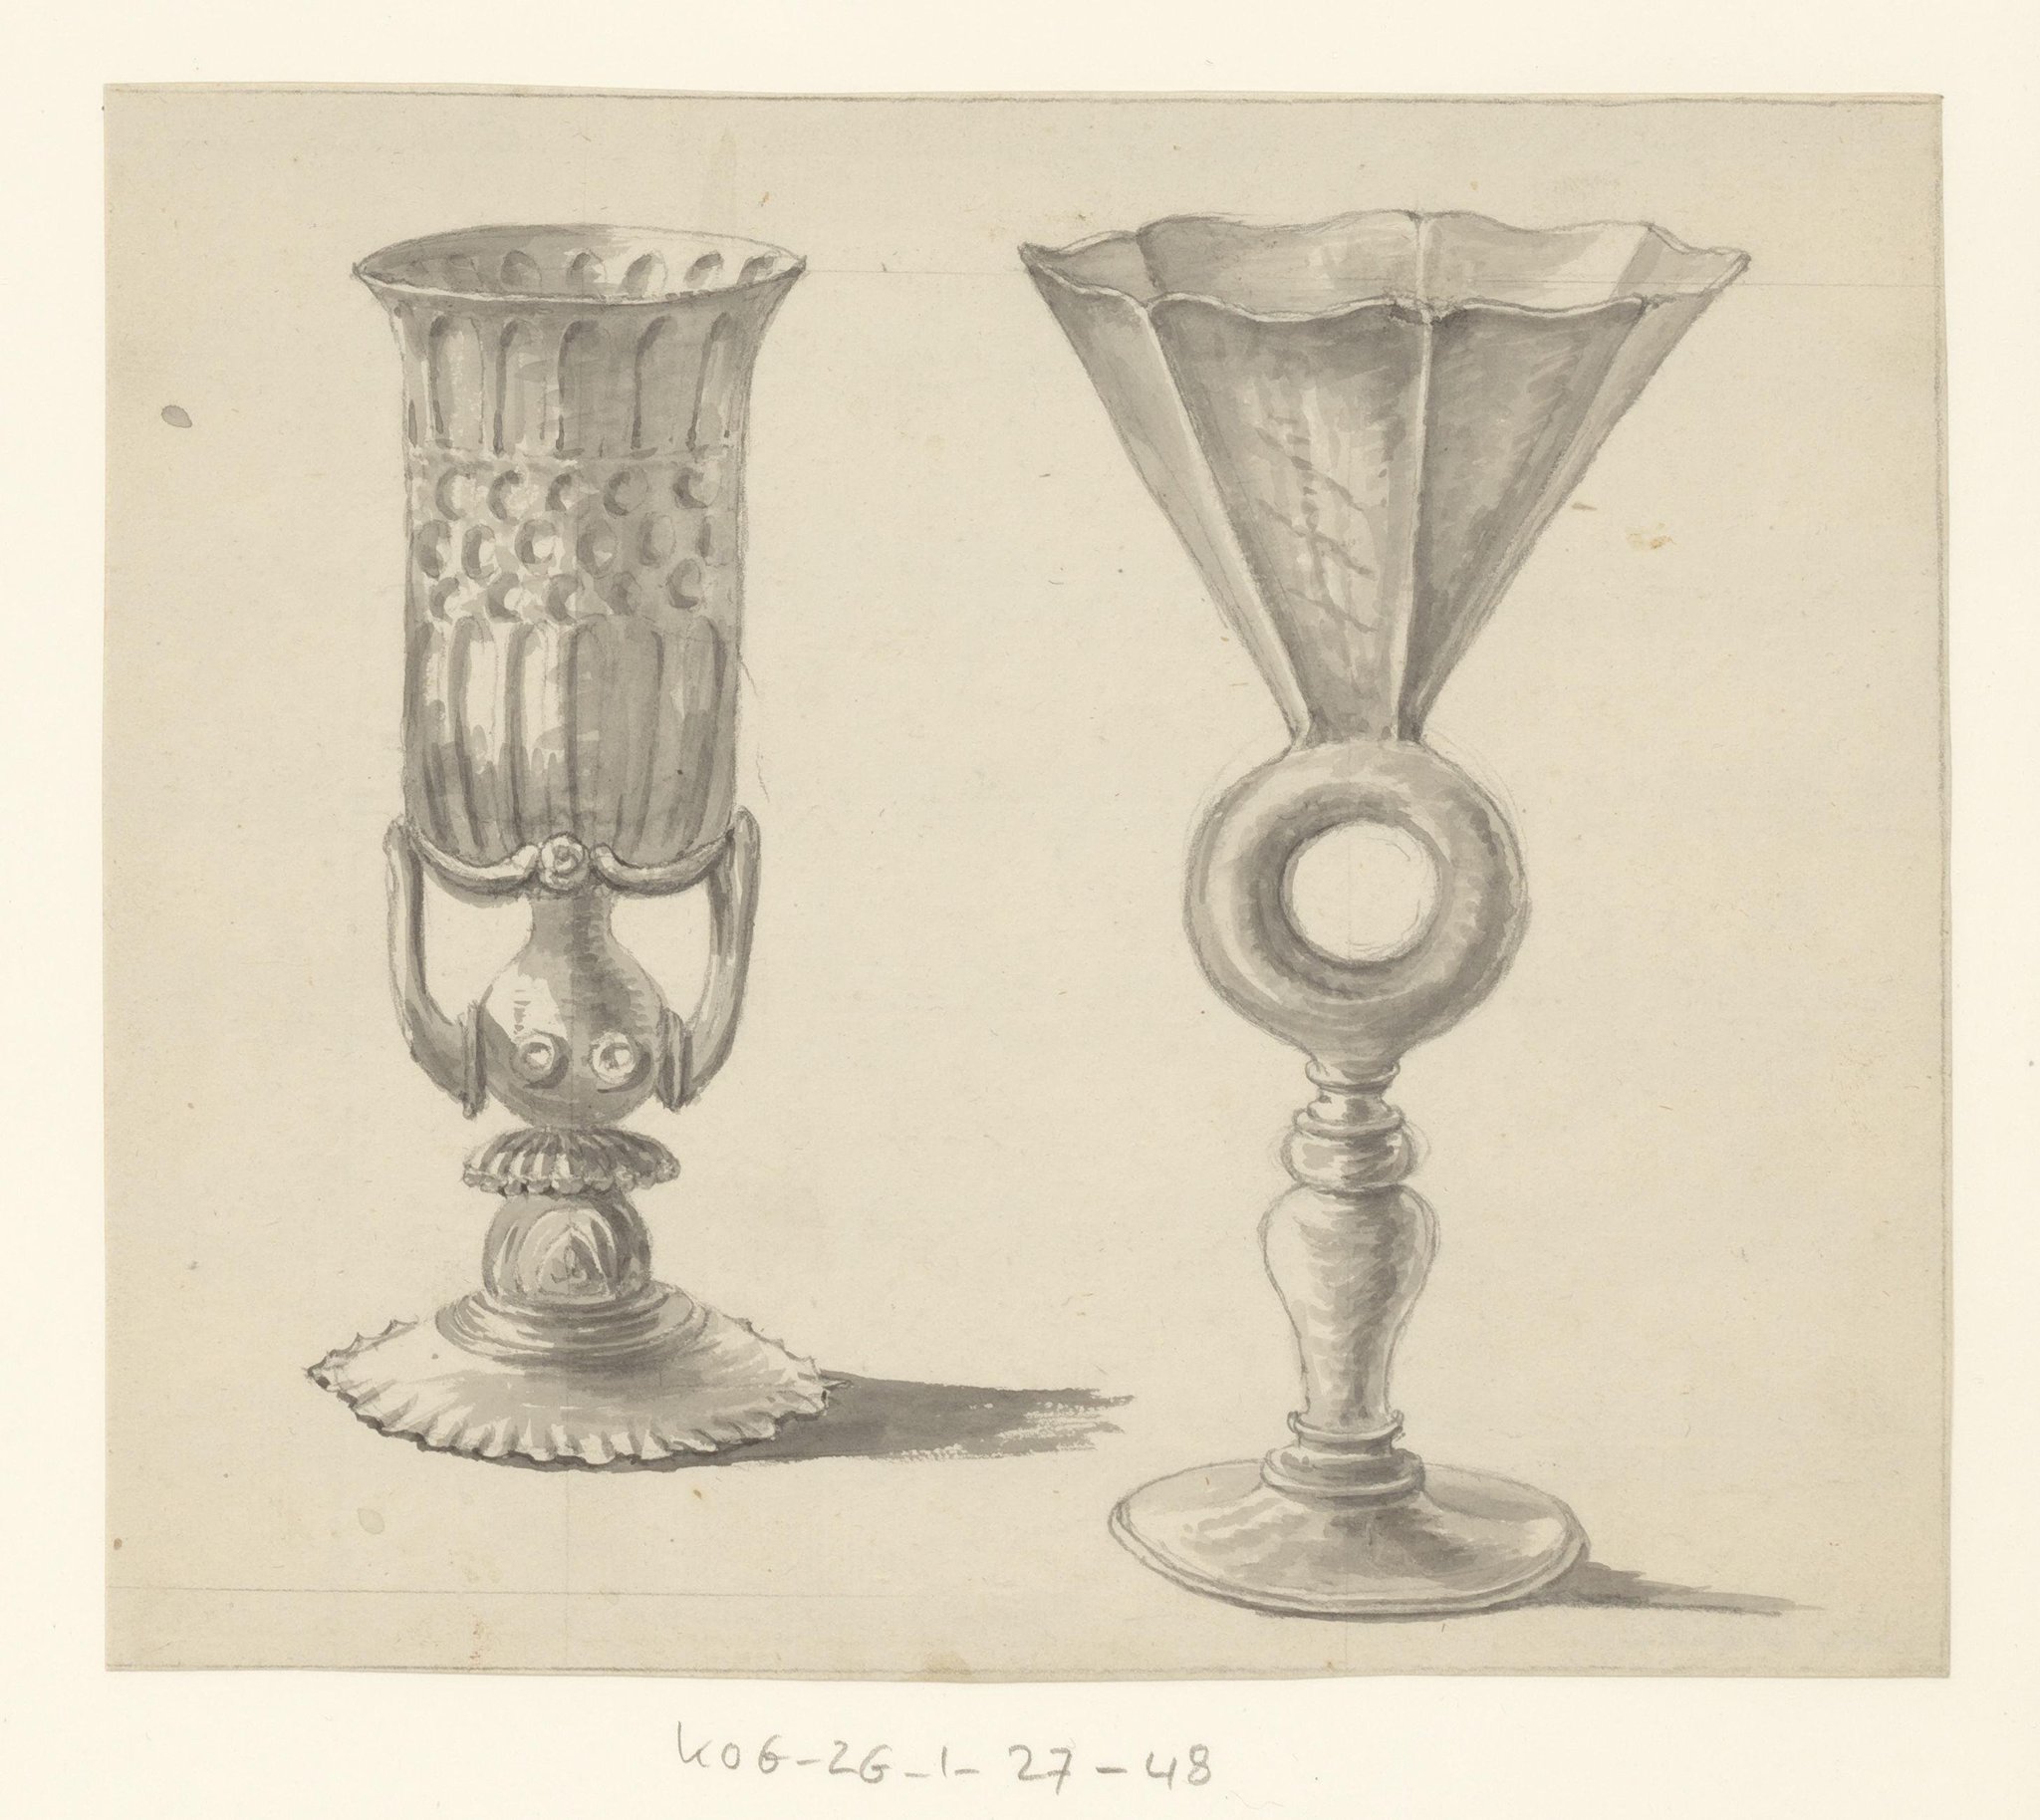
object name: drawing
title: Twee wijnglazen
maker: gerrit lamberts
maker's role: bookseller, draughtsman, print maker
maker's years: 1776-1850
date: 1790-1850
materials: chalk, ink, paper, pencil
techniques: brush, pen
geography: netherlands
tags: glass, rummer, alcoholic drinks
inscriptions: collector's mark: Lugt 1641, collector's mark